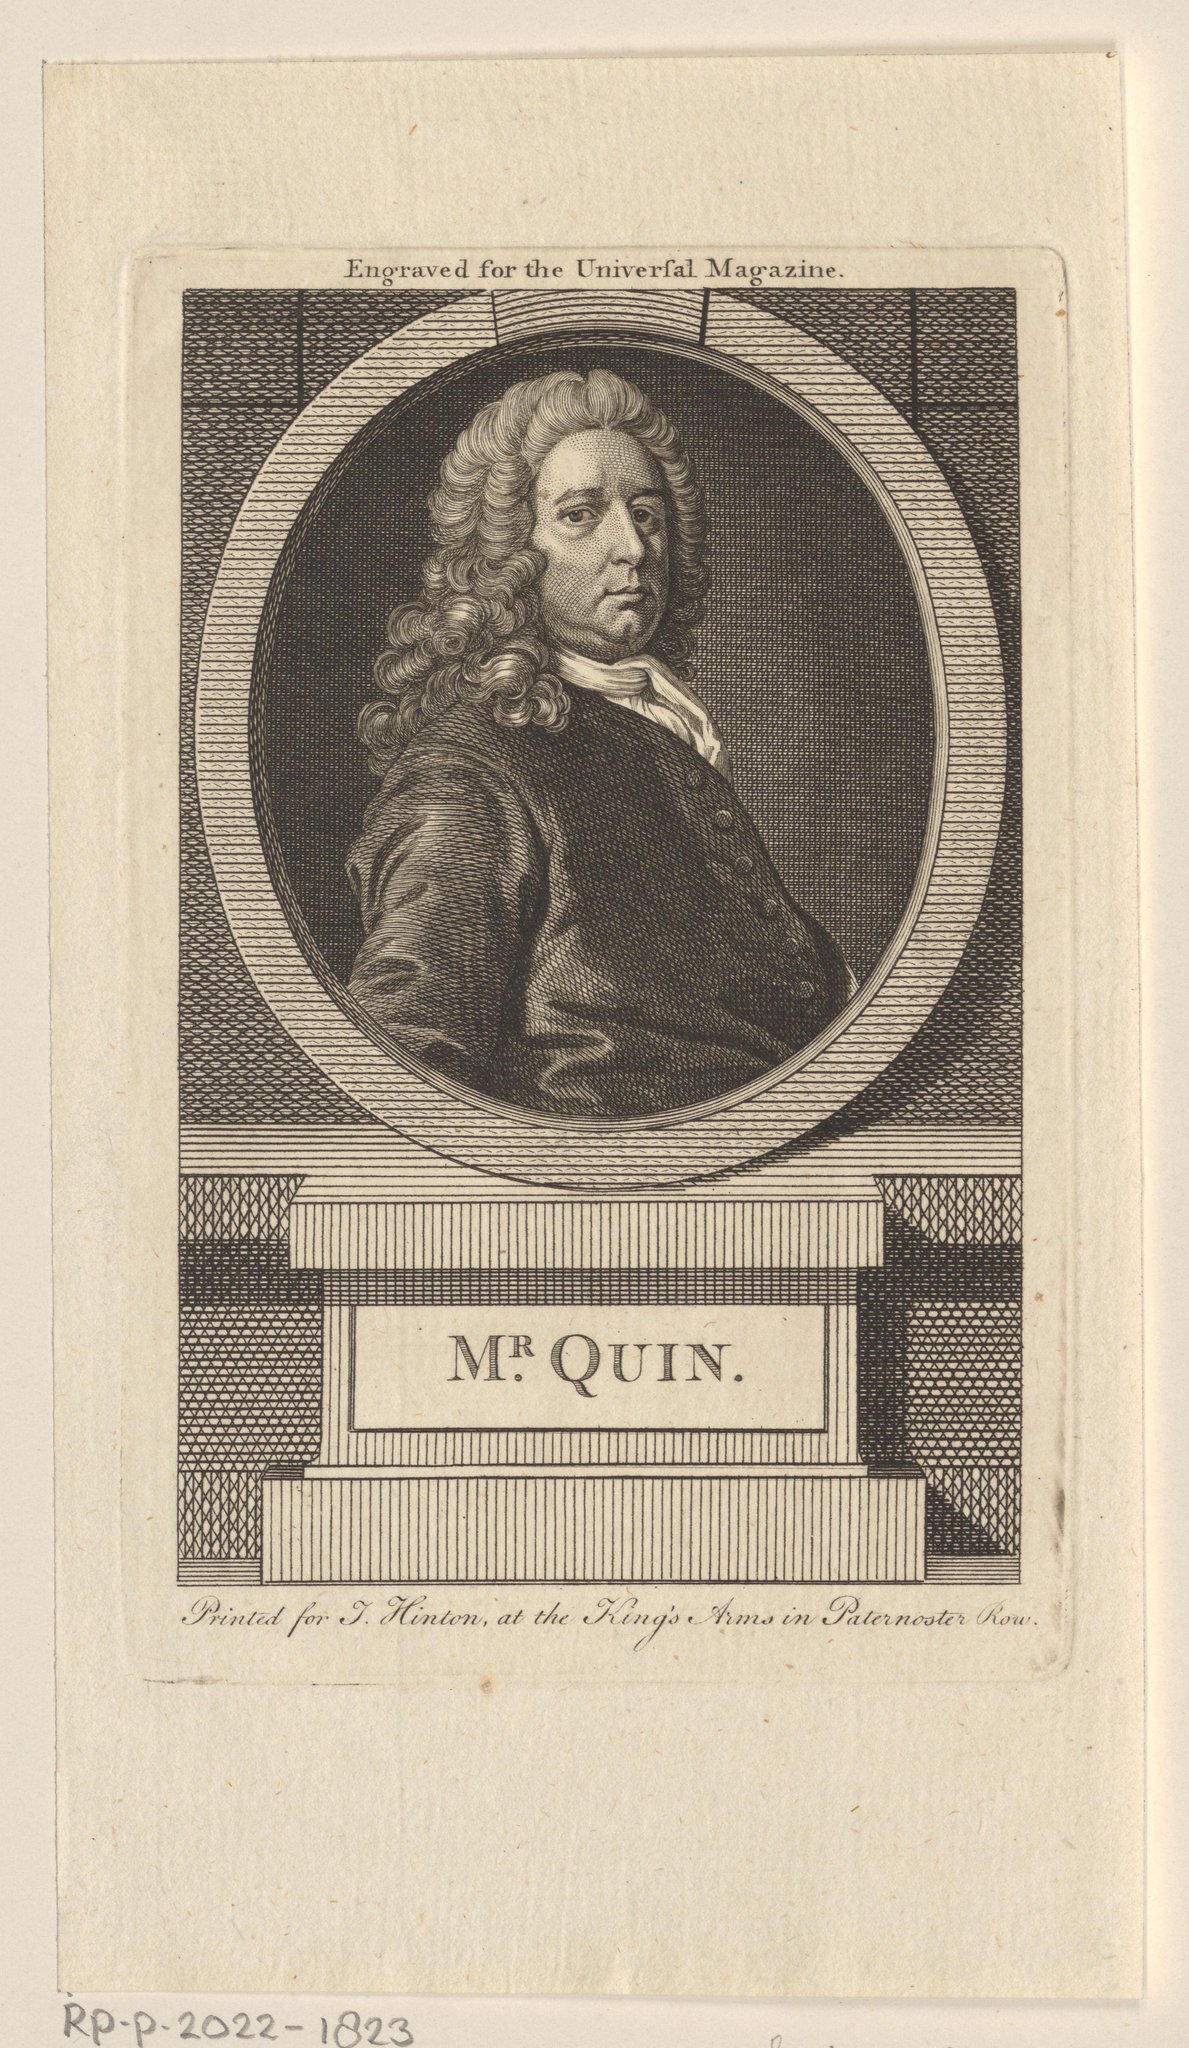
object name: print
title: Portret van James Quin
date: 1709-1775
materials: paper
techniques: engraving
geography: london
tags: historical persons, portrait of actor, actress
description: Prent mogelijk uit: The Universal Magazine of Knowledge and Pleasure 57 (1775), september 1775.